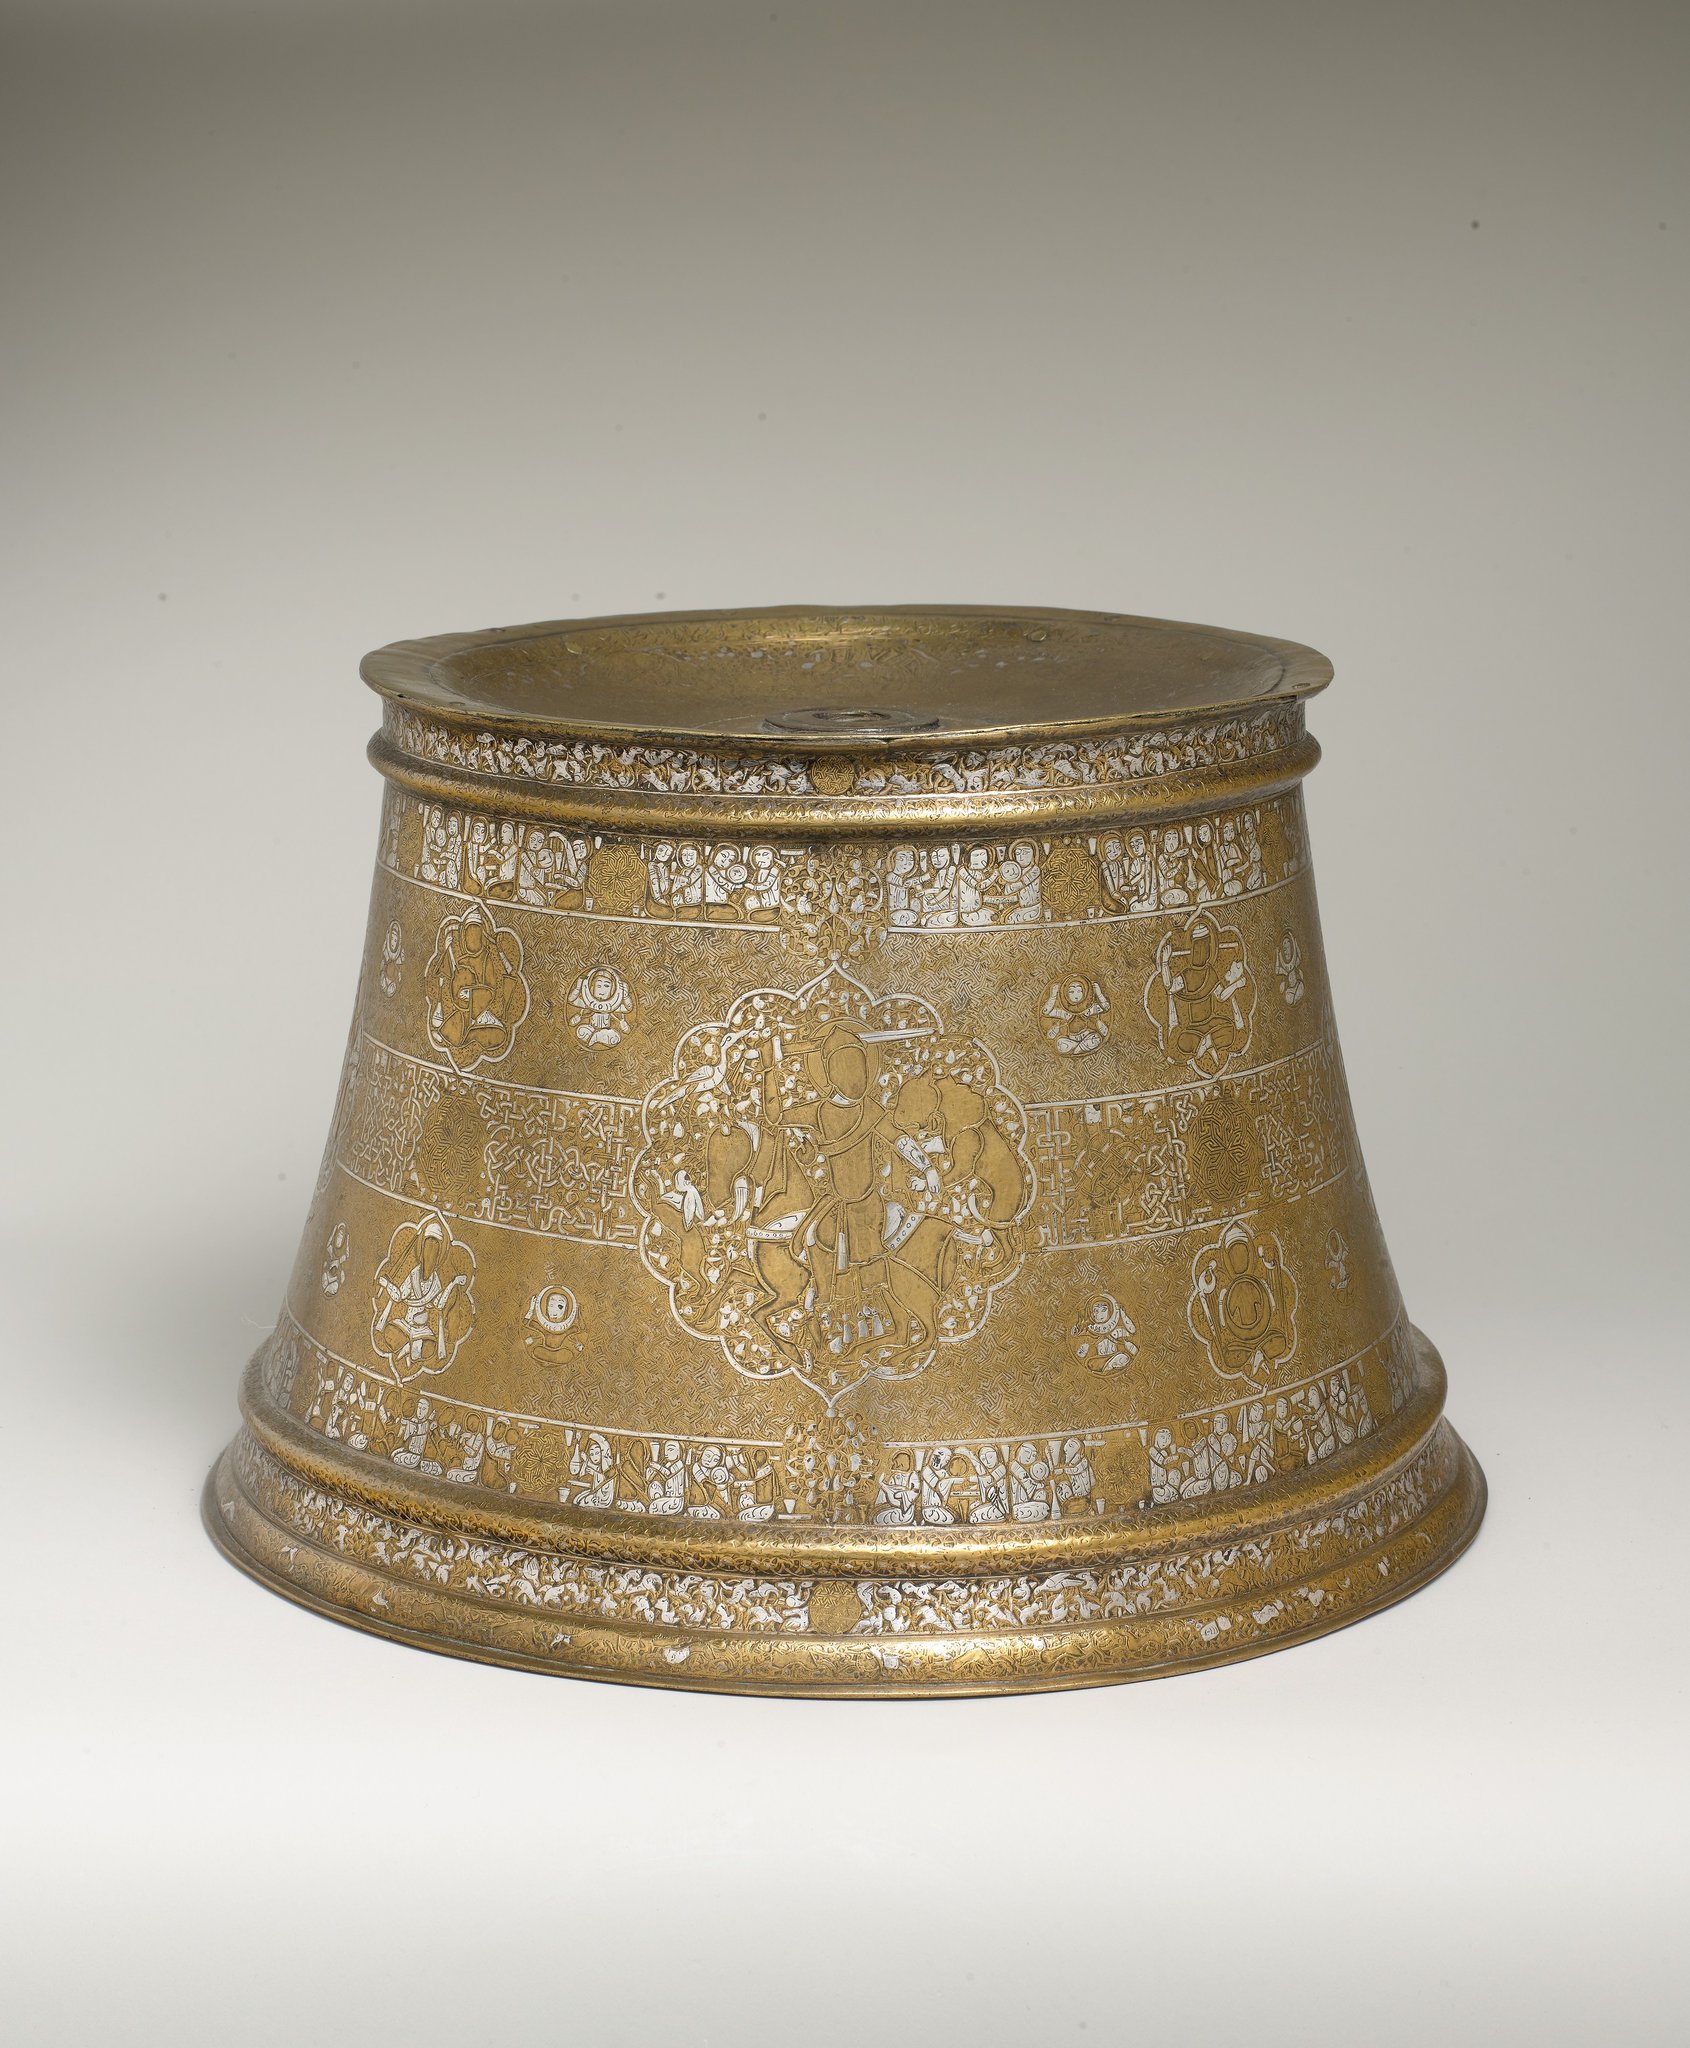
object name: candlestick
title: Candlestick with Enthronement Scene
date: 1226-1250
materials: brass, silver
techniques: engraving, incising, inlay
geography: iraq